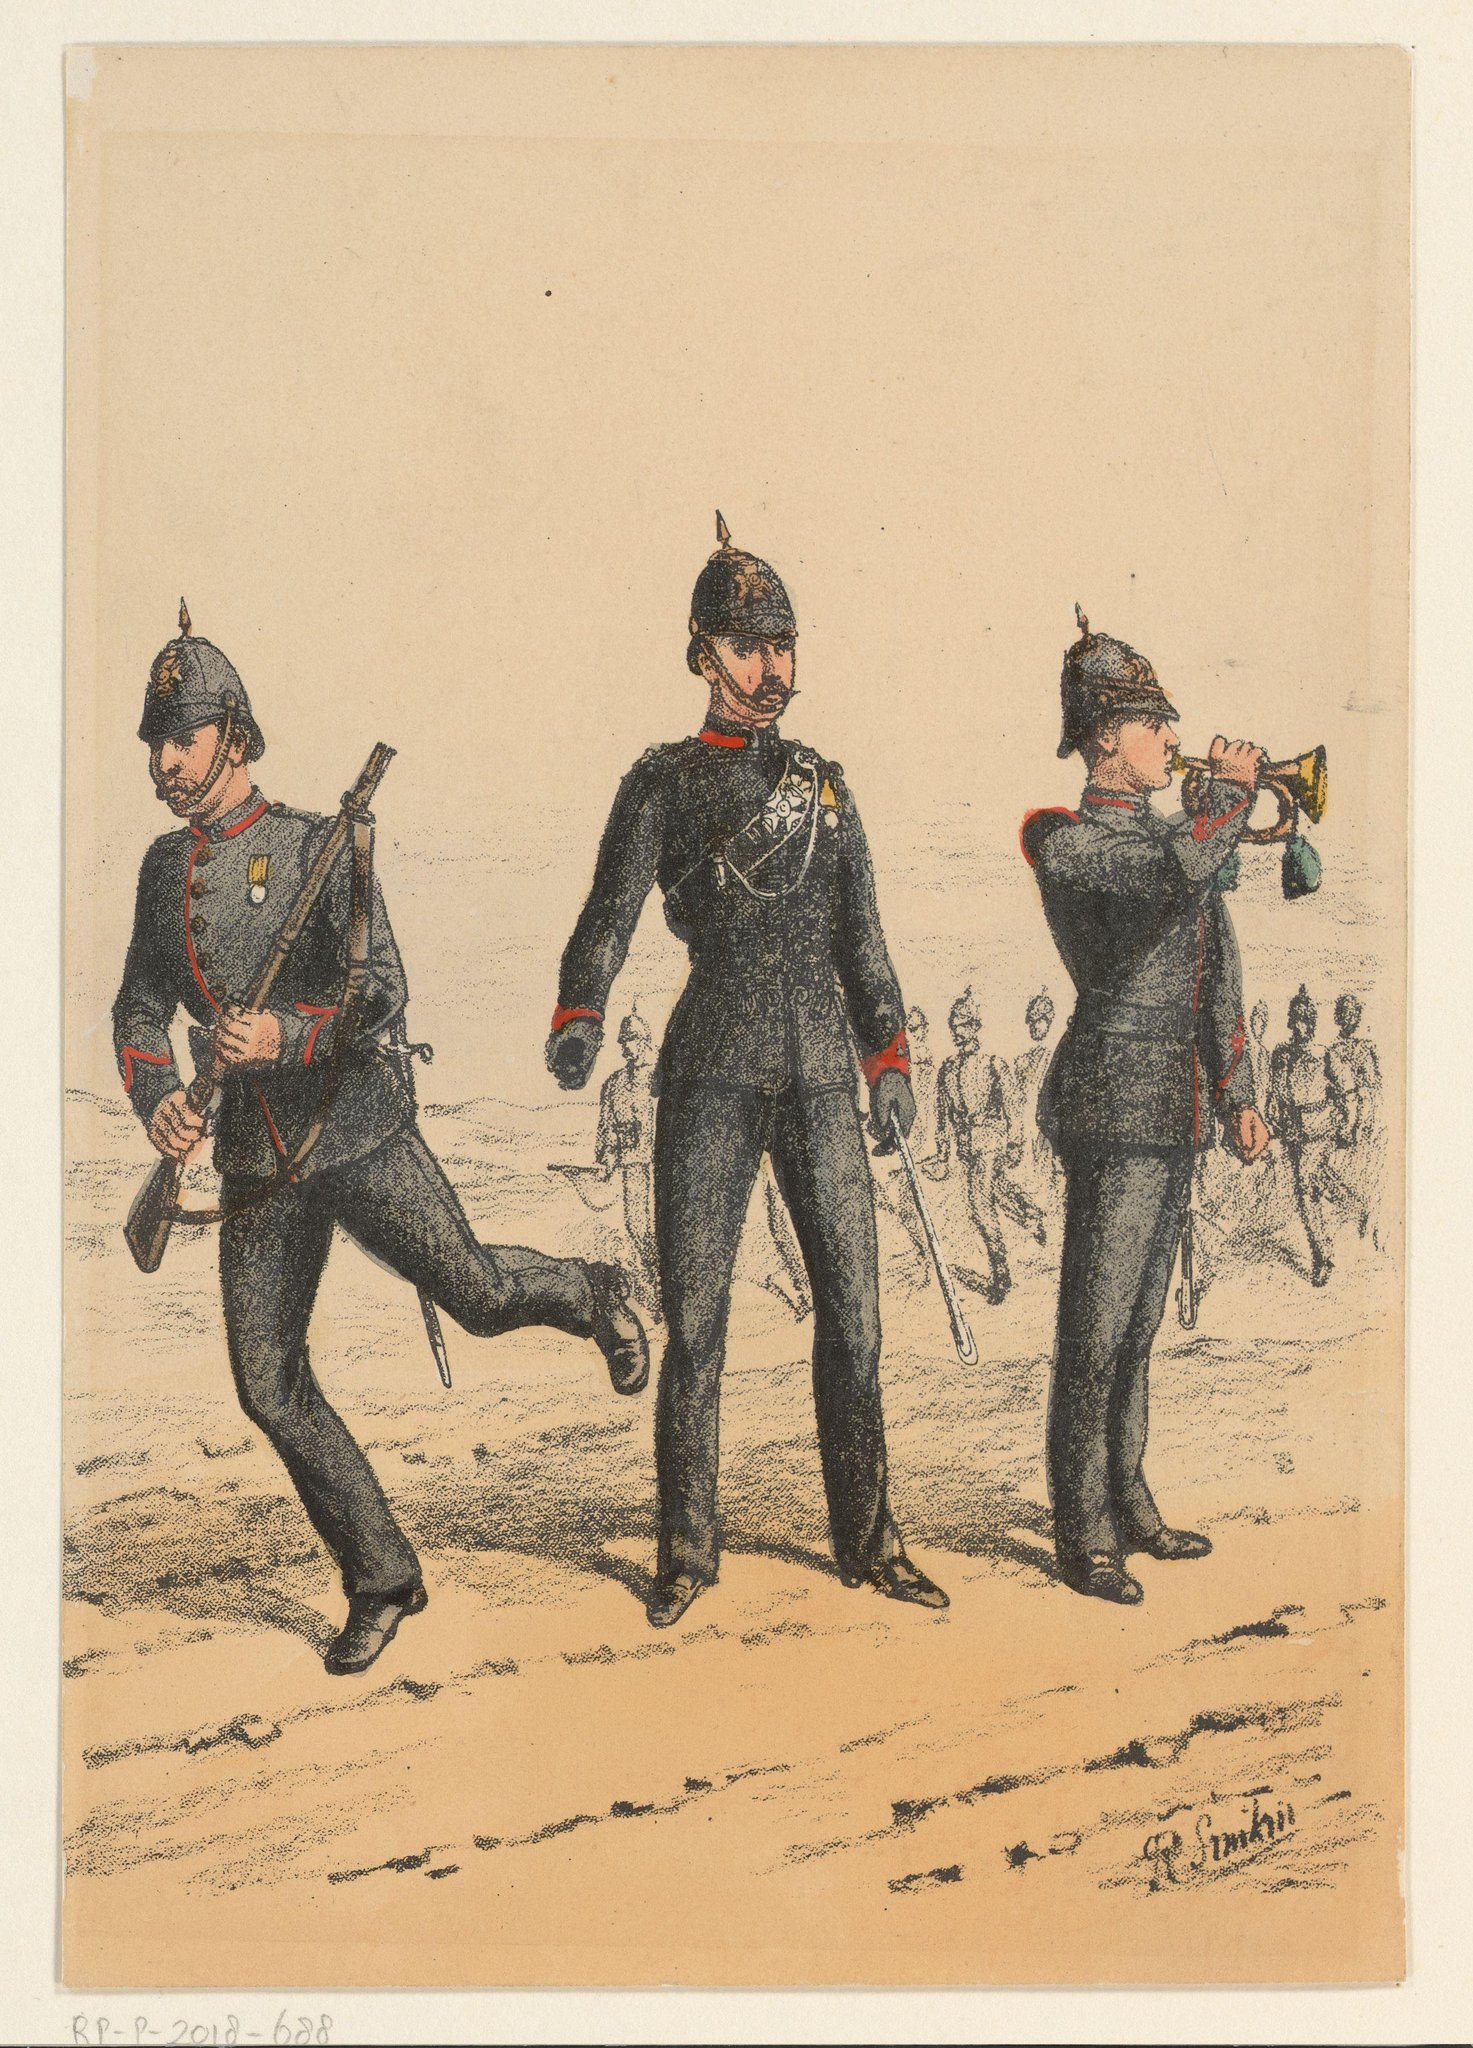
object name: print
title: Drie Britse militairen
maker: richard simkin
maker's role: draughtsman, painter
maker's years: 1840-1926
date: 1875-1925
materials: lacquer, paper, watercolor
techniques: hand coloring, lacquer, lithograph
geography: england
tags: (military) uniforms, great britain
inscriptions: collector's mark: Lugt 2228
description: Drie staande Britse militairen, één blaast op de bugel. Onderdeel van een serie van negen voorstellingen van Britse militaire uniformen.